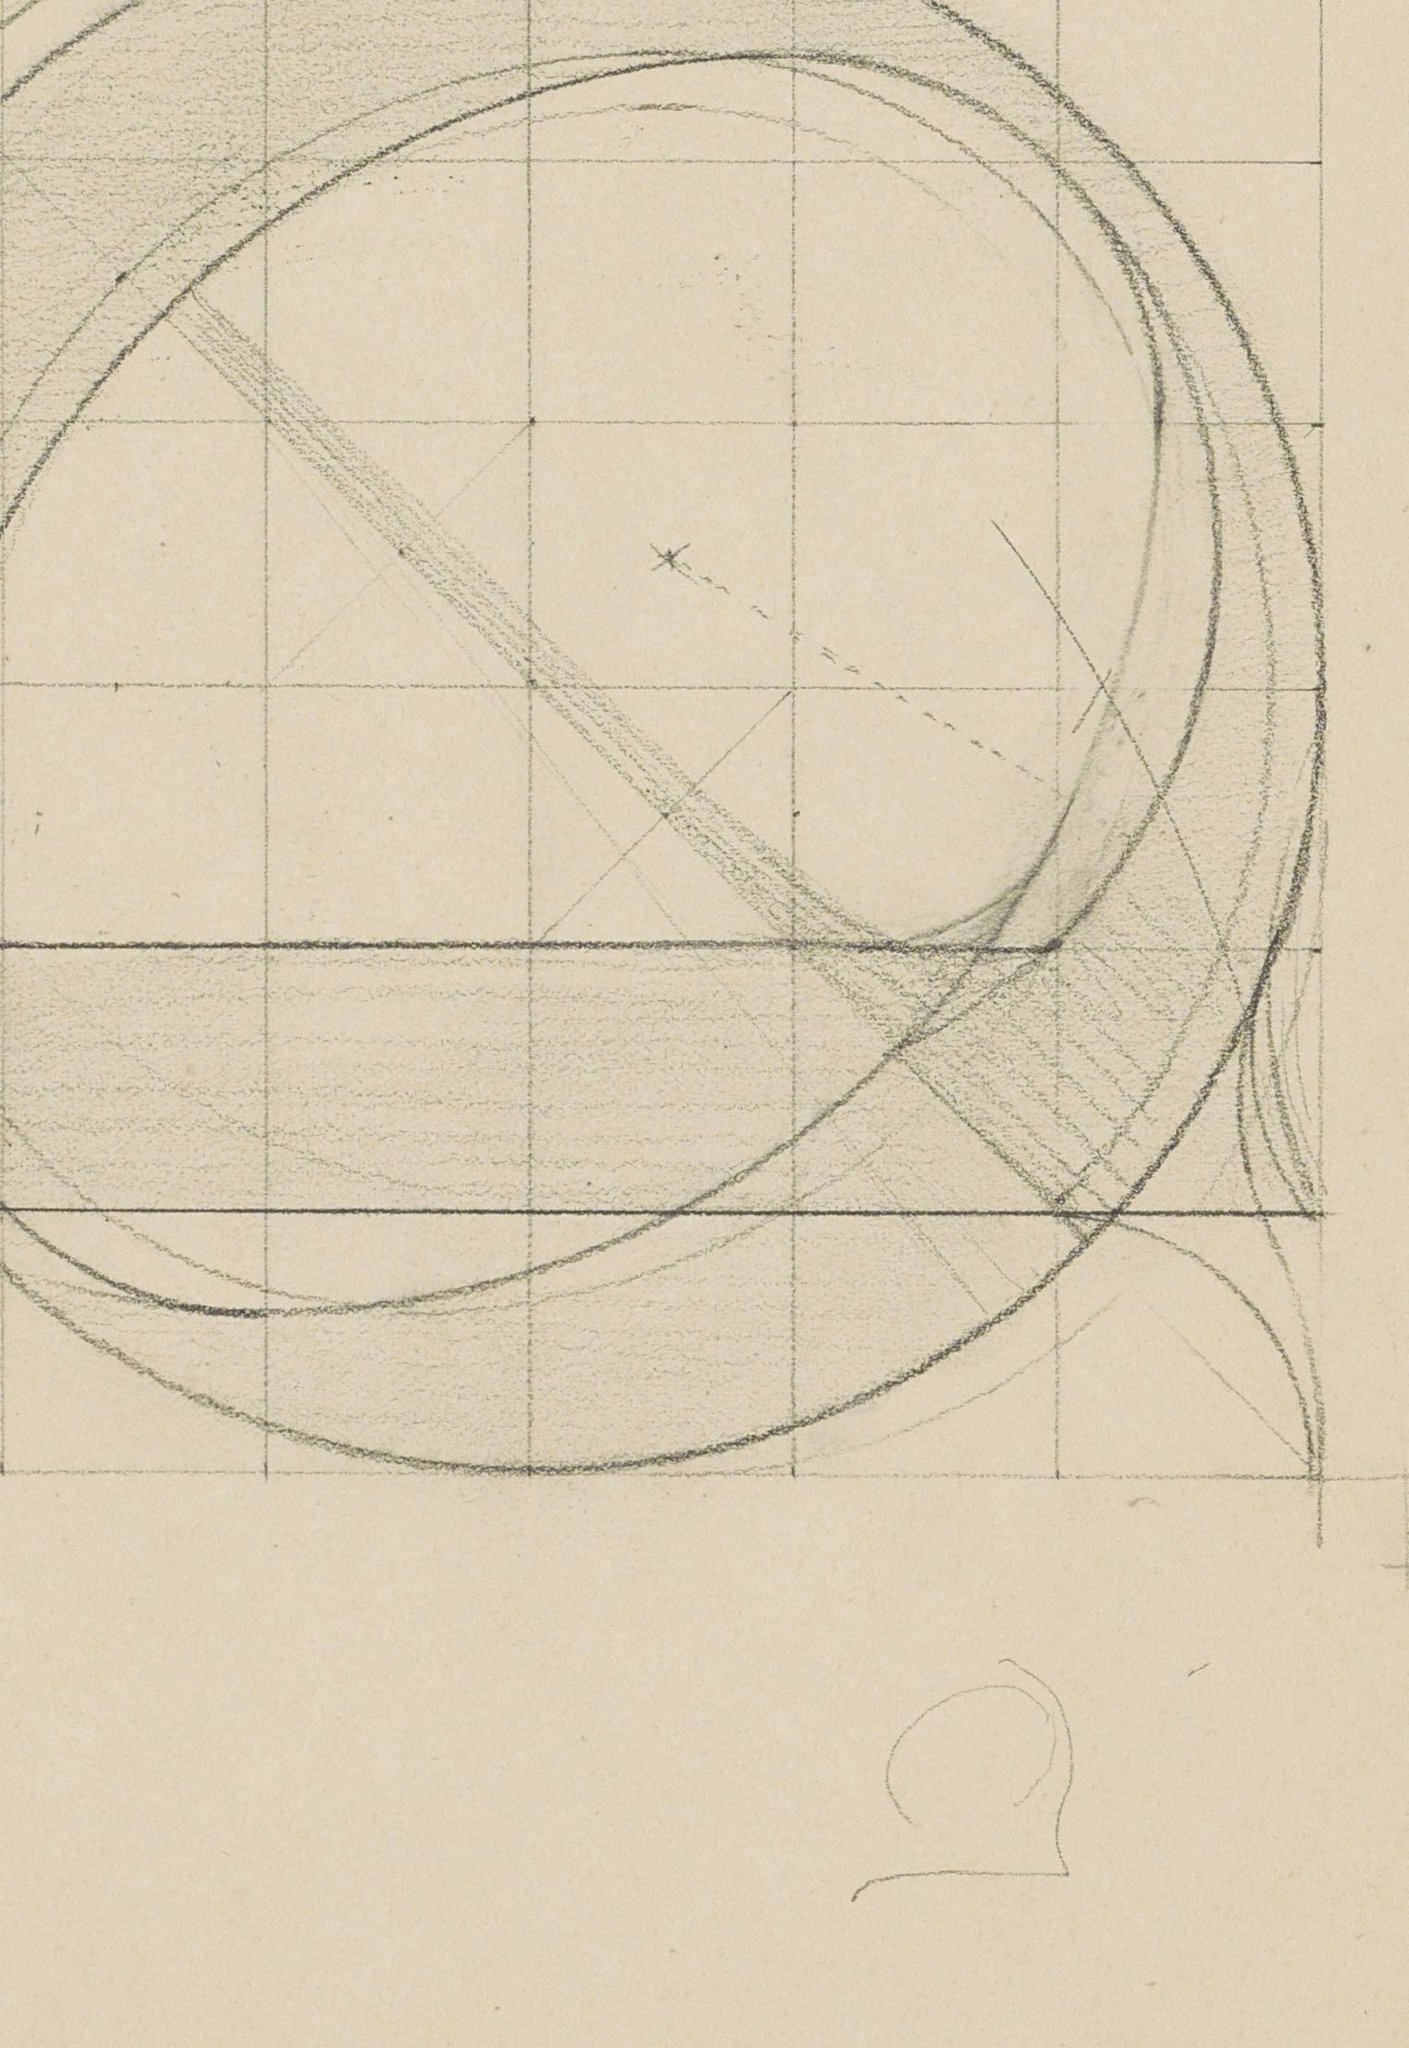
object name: sketchbook leaf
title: Letter 'D'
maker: antoon derkinderen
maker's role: draughtsman, painter, print maker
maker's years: 1859-1925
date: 1889-1894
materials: paper, pencil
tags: fancy letters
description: Blad 15 verso uit een schetsboek met 33 bladen.